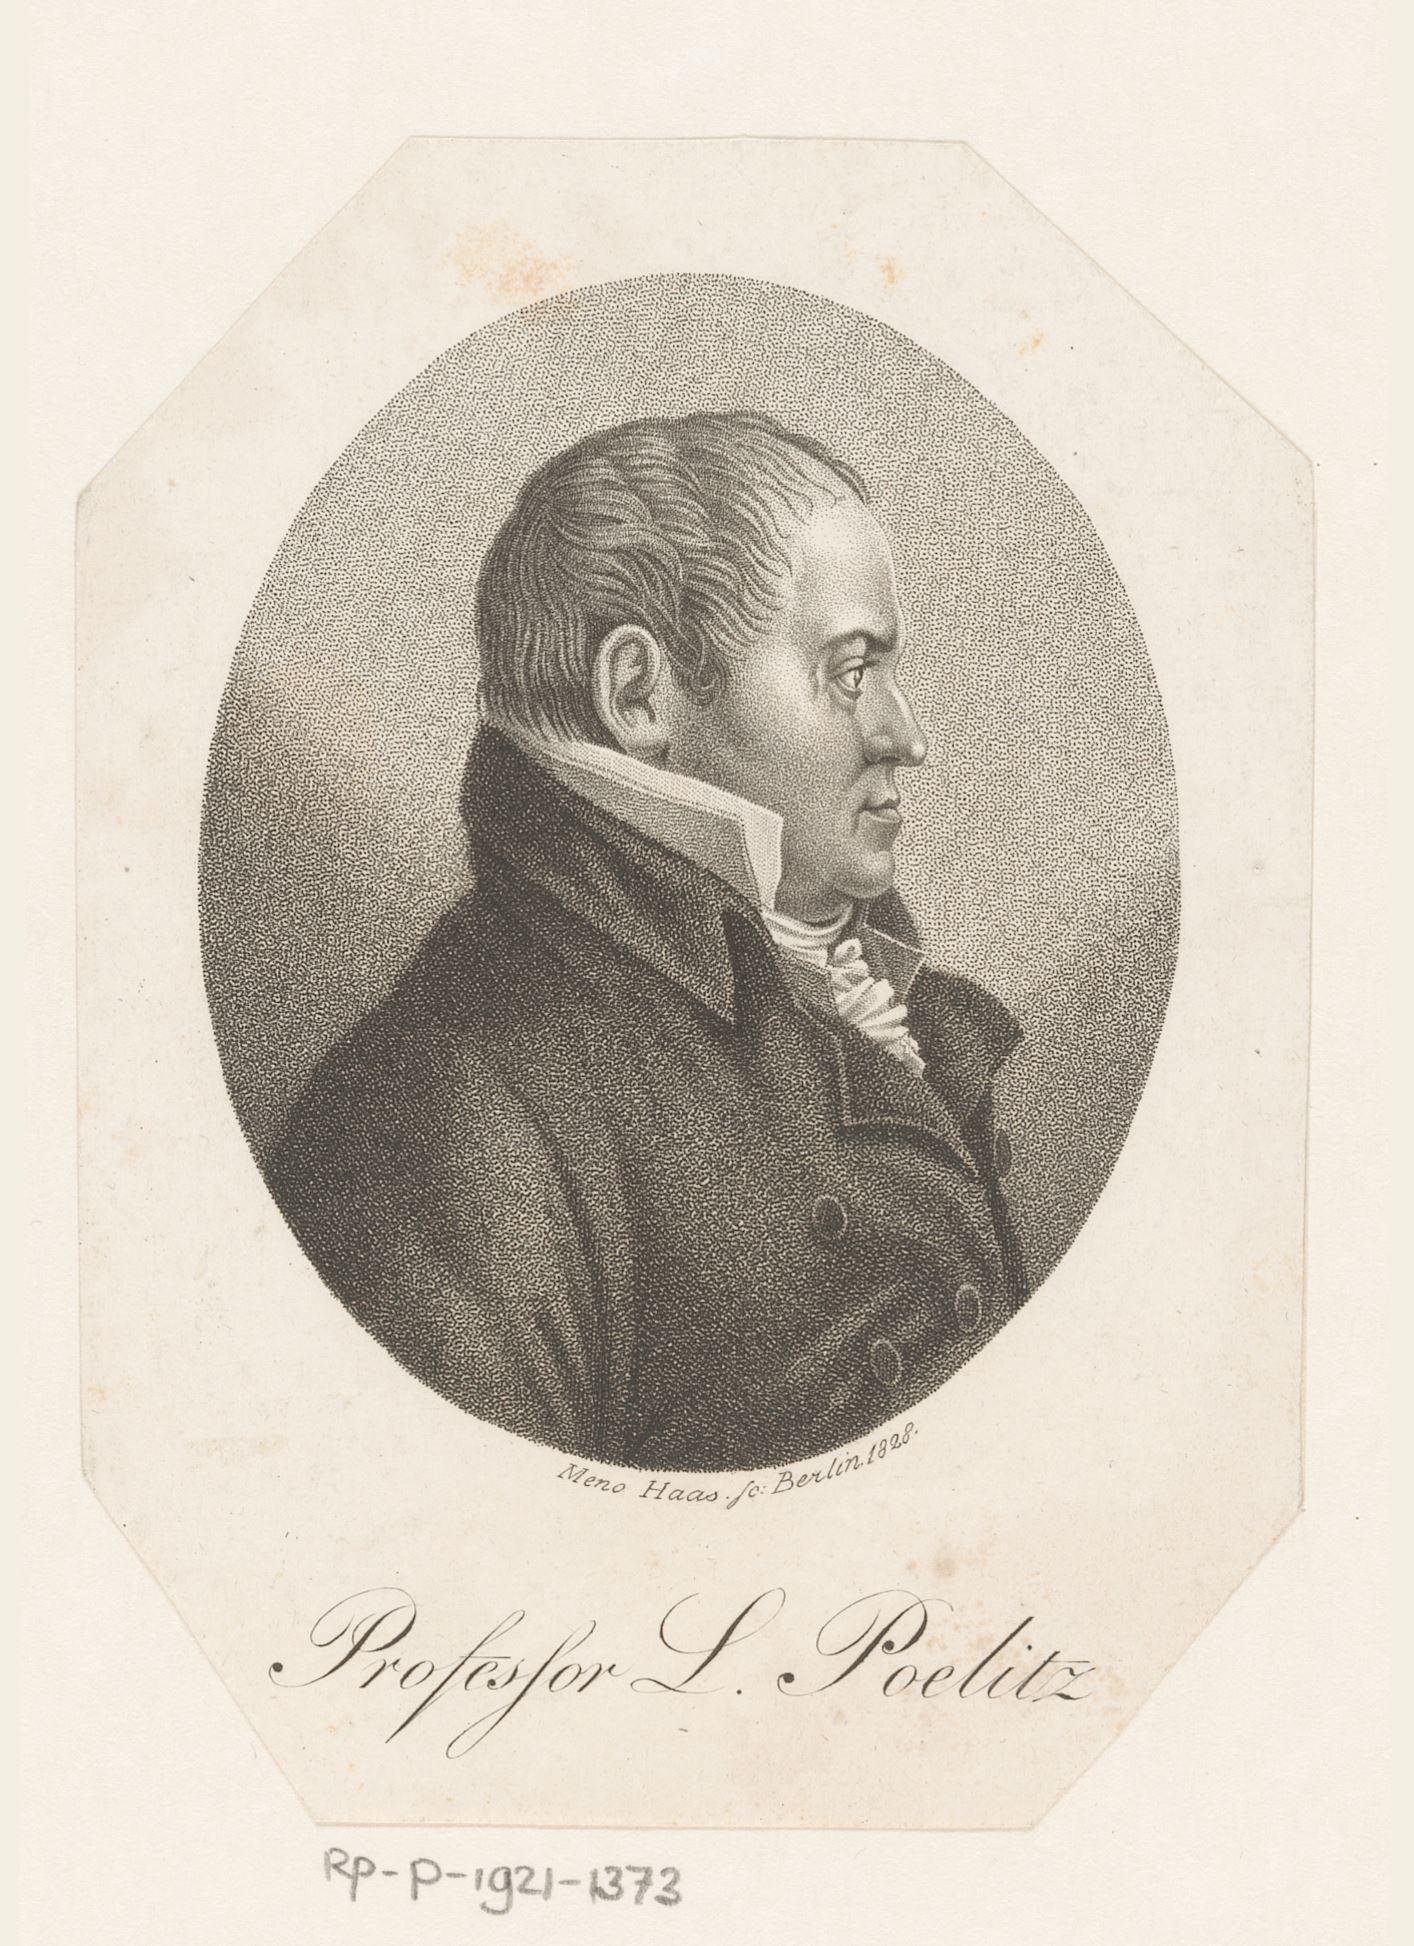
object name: print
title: Portret van Karl Heinrich Ludwig Pölitz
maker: meno haas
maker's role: print maker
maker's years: 1752-1833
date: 1828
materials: paper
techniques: stippling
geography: berlin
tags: historical persons, portrait of a writer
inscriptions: collector's mark: Lugt 2233